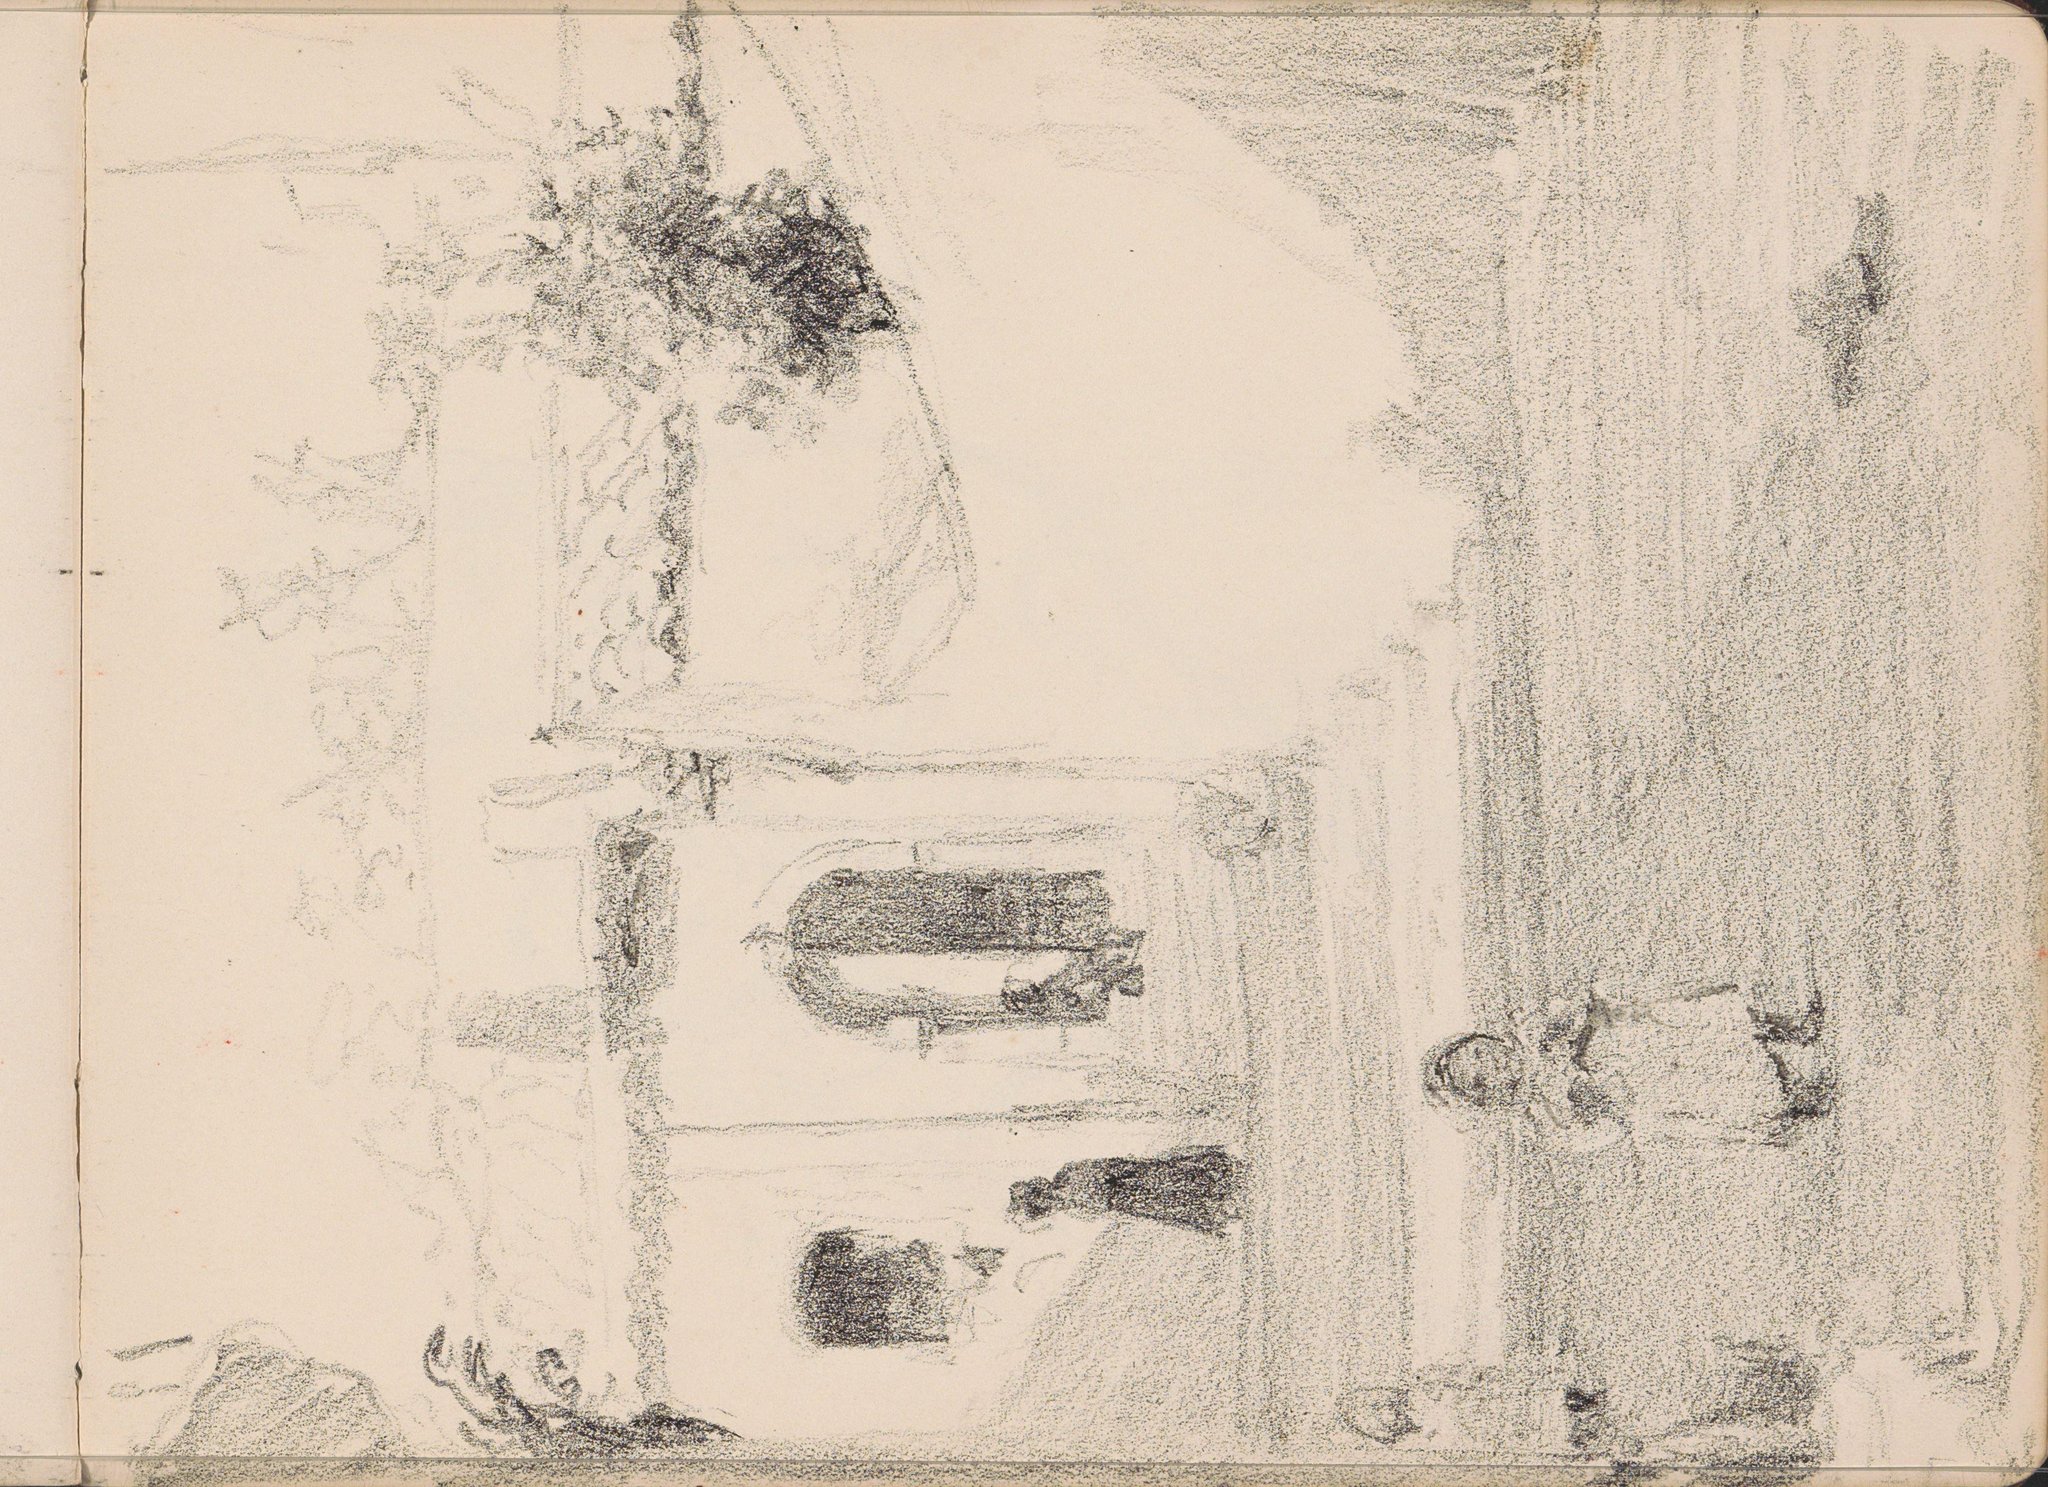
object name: sketchbook leaf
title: Figuren op een trap leidend naar een huis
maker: a.a.l. de grammont-hubrecht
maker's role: draughtsman, painter, print maker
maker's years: 1855-1913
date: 1865-1913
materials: chalk, paper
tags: flight of steps, street (+ city(-scape) with figures, staffage)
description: Blad 32 recto uit een schetsboek met 39 bladen.